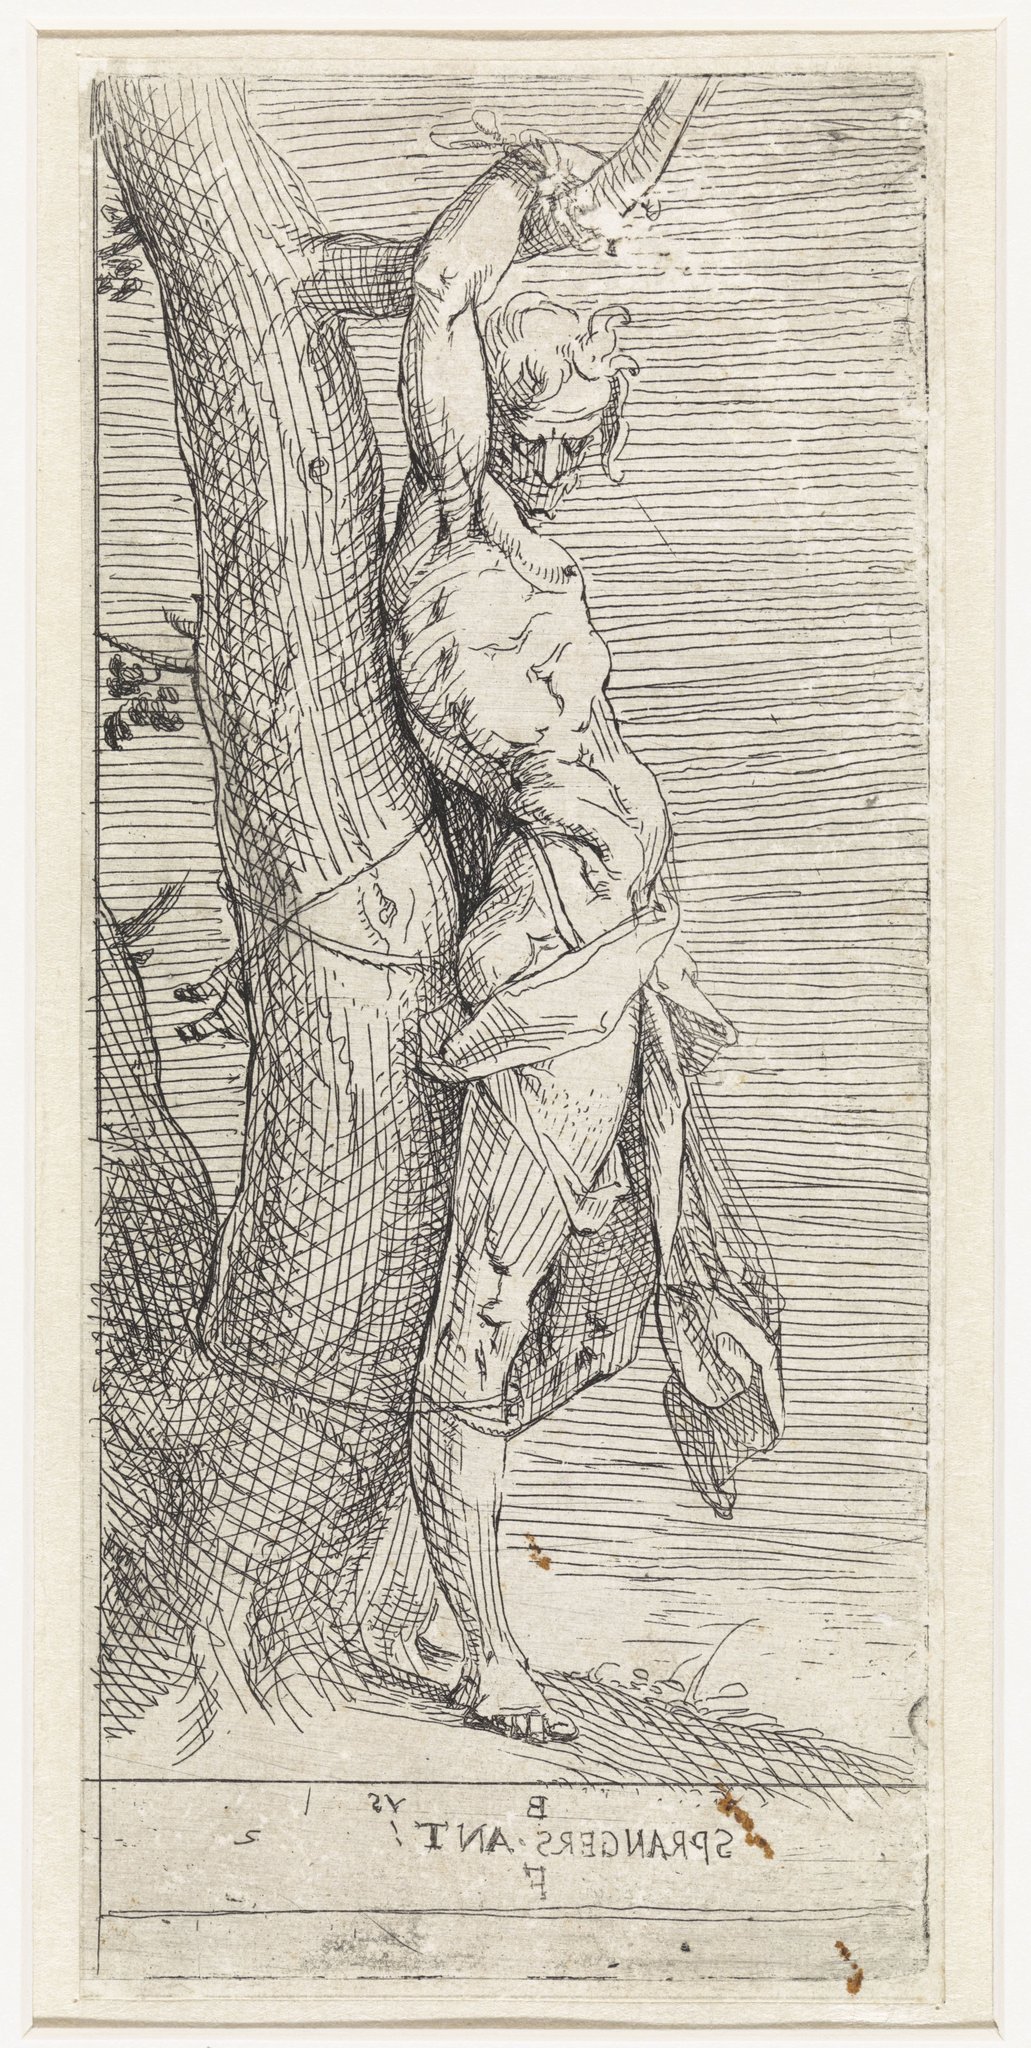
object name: print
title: Martelaarschap van de H. Sebastiaan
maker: bartholomeus spranger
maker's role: draughtsman, painter, print maker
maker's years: 1546-1611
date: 1557-1564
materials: paper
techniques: etching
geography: antwerp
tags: martyrdom, suffering, misfortune, death of st. sebastian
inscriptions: collector's mark: Lugt 2228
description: De heilige Sebastiaan is aan een boom vastgebonden.